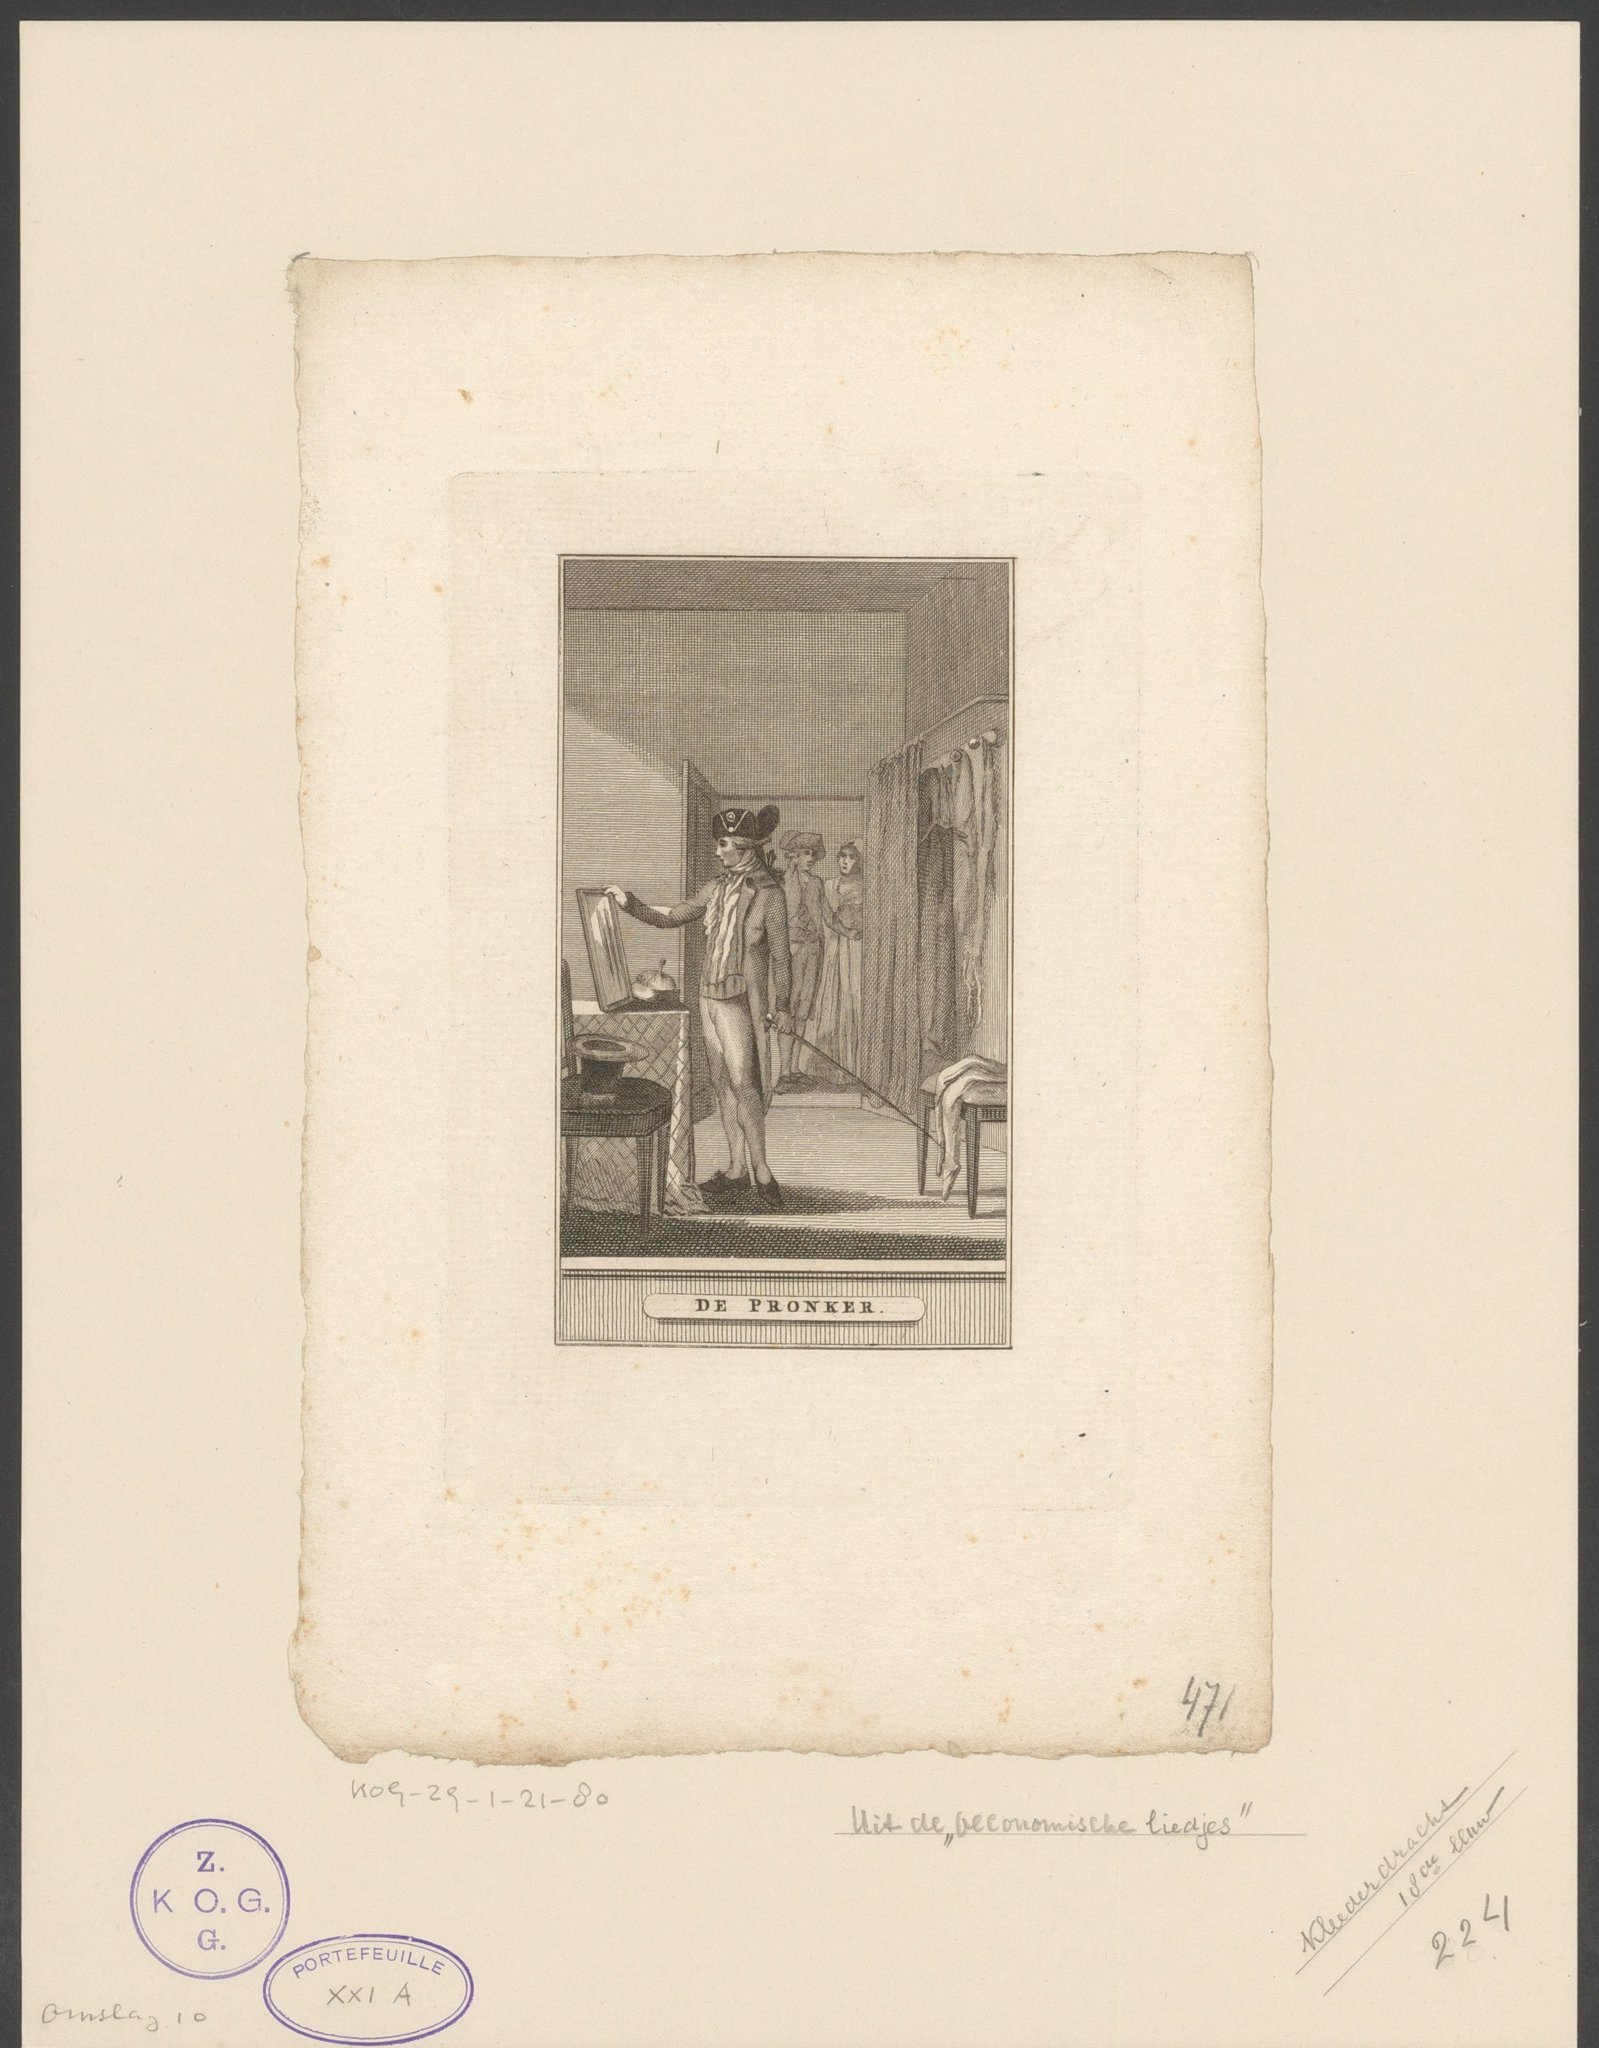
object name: print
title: Jonge man bekijkt zichzelf in de spiegel in een kledingwinkel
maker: Anonymous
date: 1798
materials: paper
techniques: etching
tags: shop, store, mirror, looking in the mirror; contemplation of own beauty, adult man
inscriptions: stamp, collector's mark: Lugt 1641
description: Onderwerpsrubrieken binnen de Atlas Zeden en Gewoonten: Zeden en Gewoonten in Engeren Zin, De Kleeding, Kleederdrachten (tijdvakken), De 18de eeuw (de pruikentijd). Mannen en vrouwen.